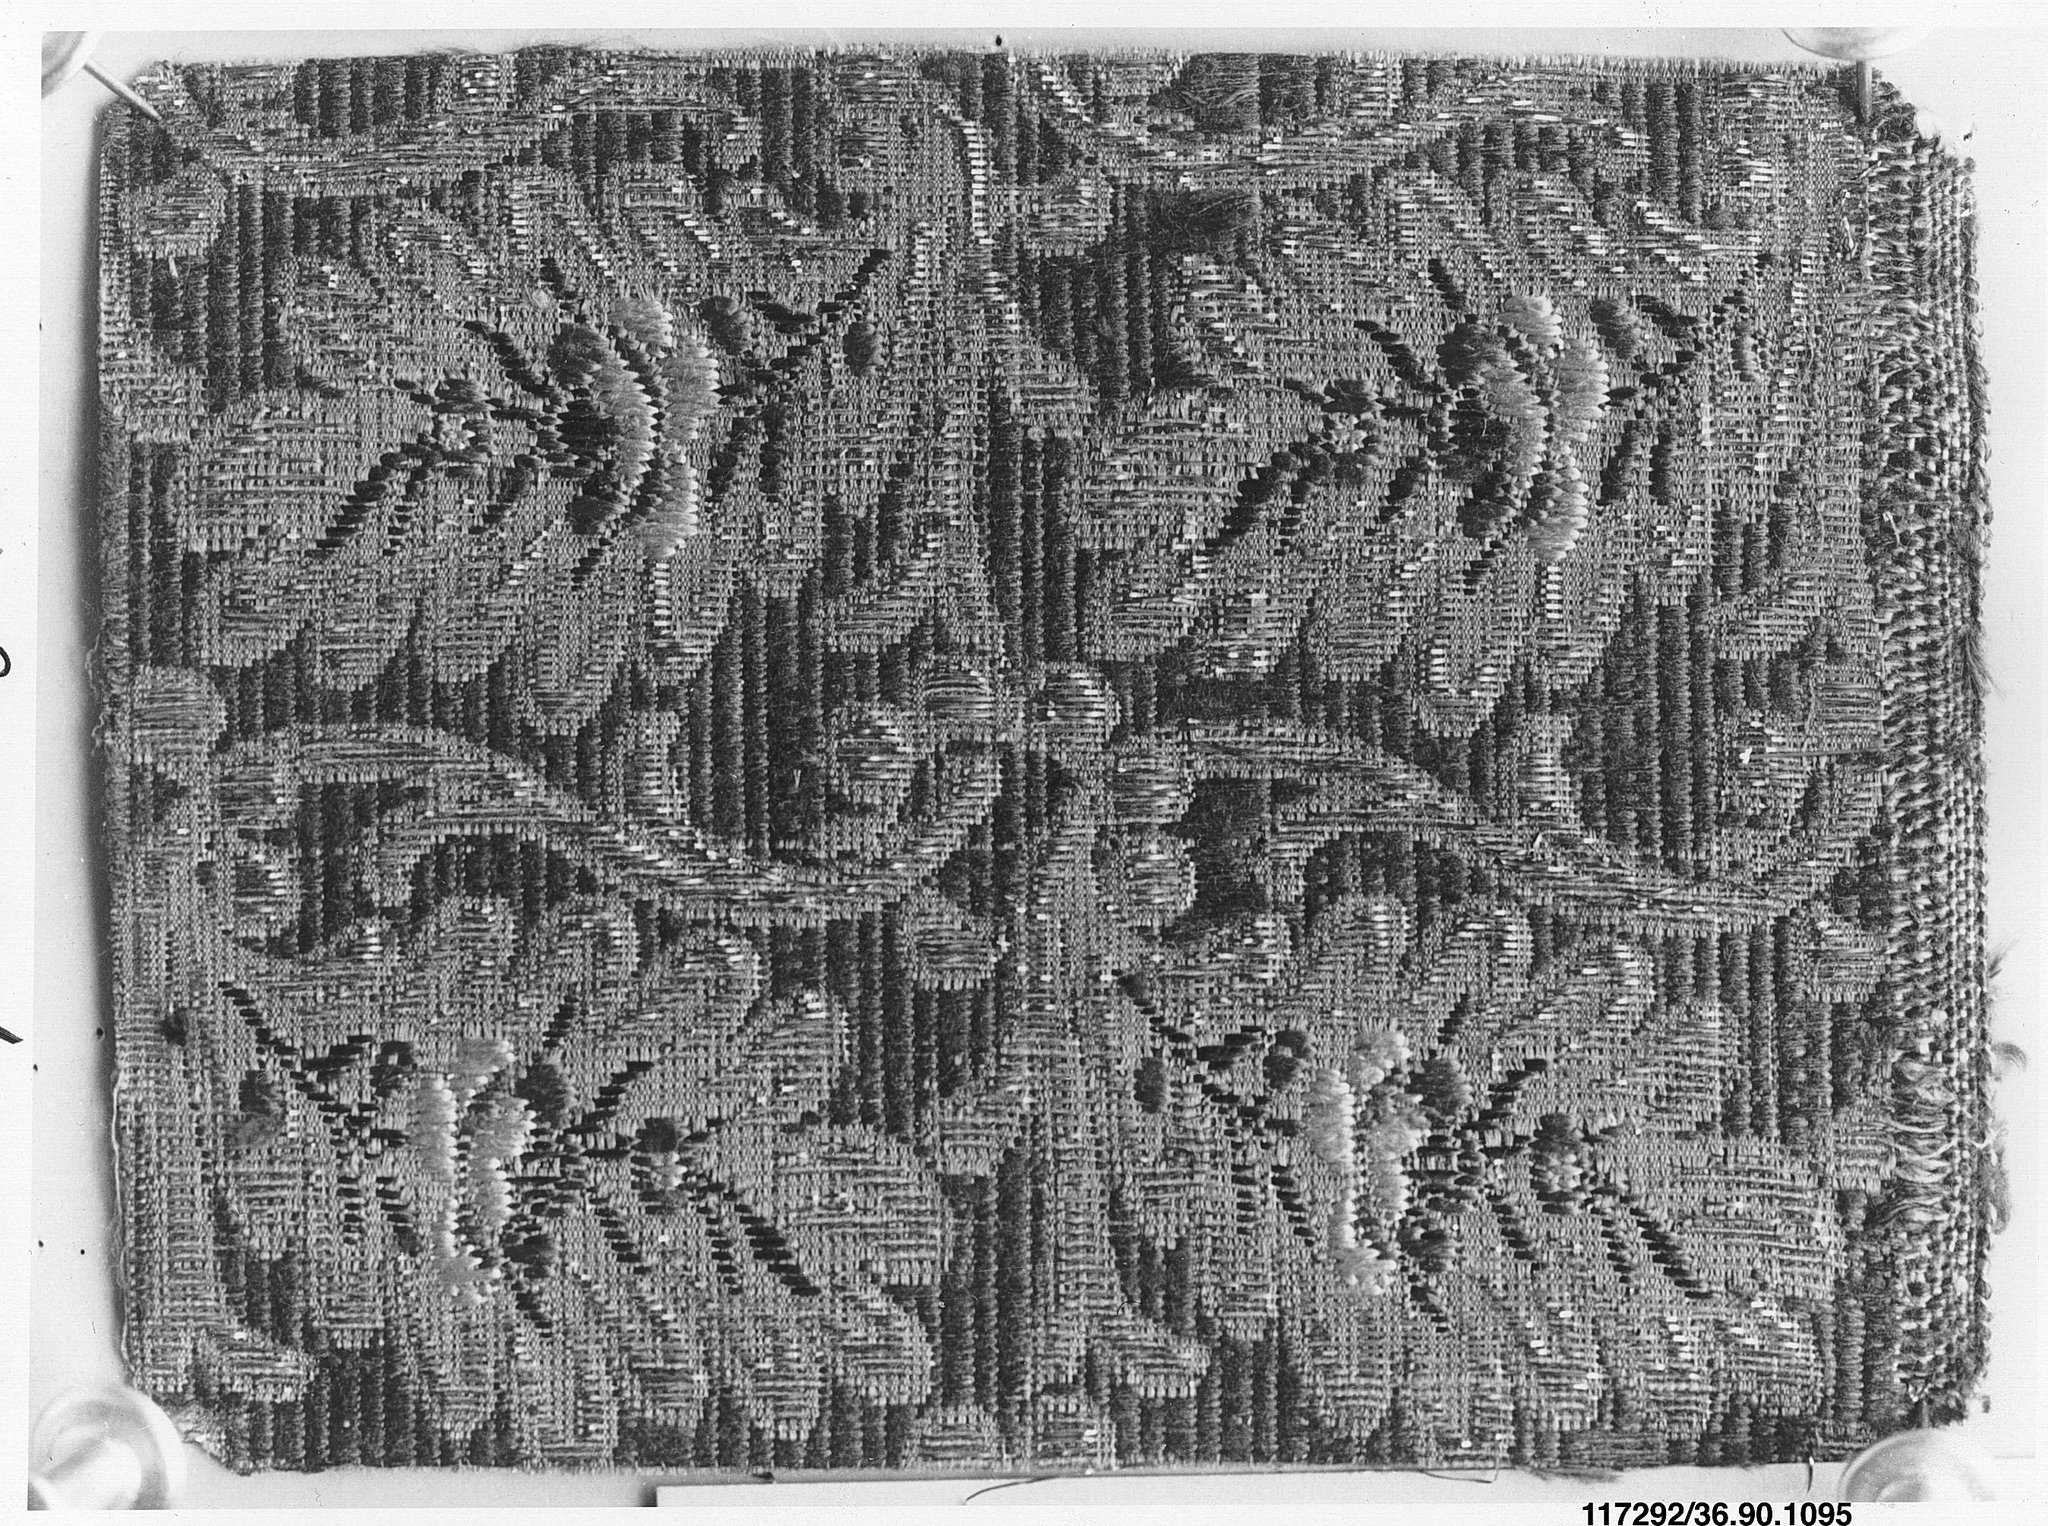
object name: sample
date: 1701-1900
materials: metal thread, silk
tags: leaves